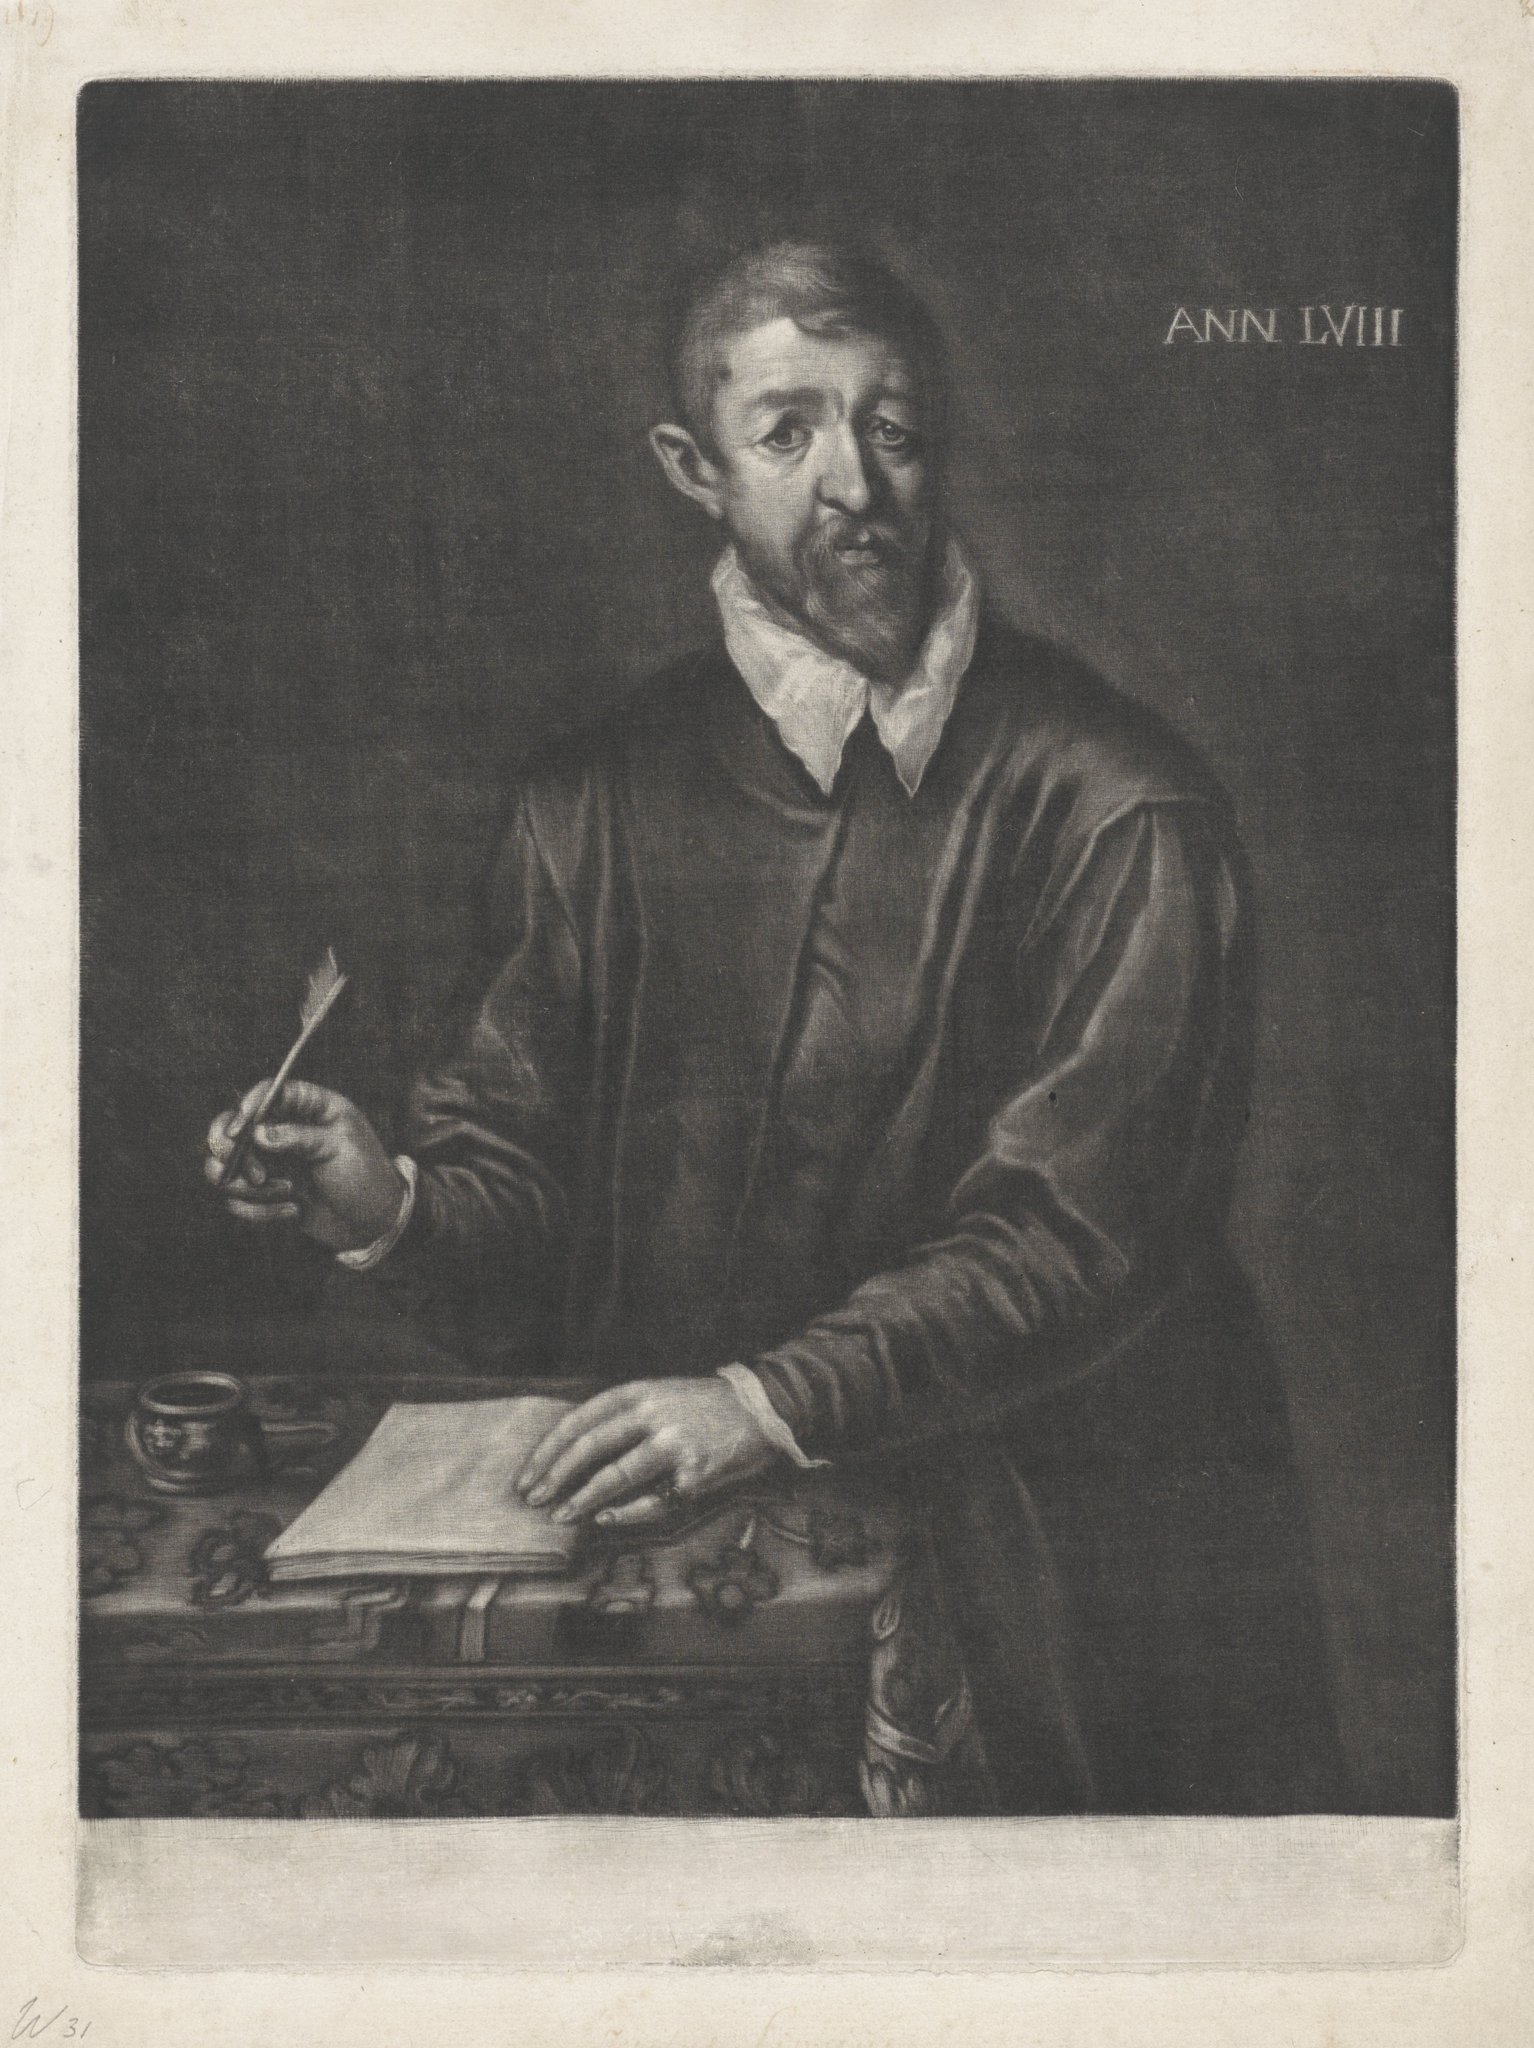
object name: print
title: Portret van een man bij een tafel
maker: Anonymous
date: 1658-1727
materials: paper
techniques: mezzotint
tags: quill, writing tools, ring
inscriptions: collector's mark: Lugt 2228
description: Een 58-jarige man bij een tafel met een schrijfveer in de hand. Hij staat op het punt om het lege blad, dat voor hem ligt, te beschrijven.